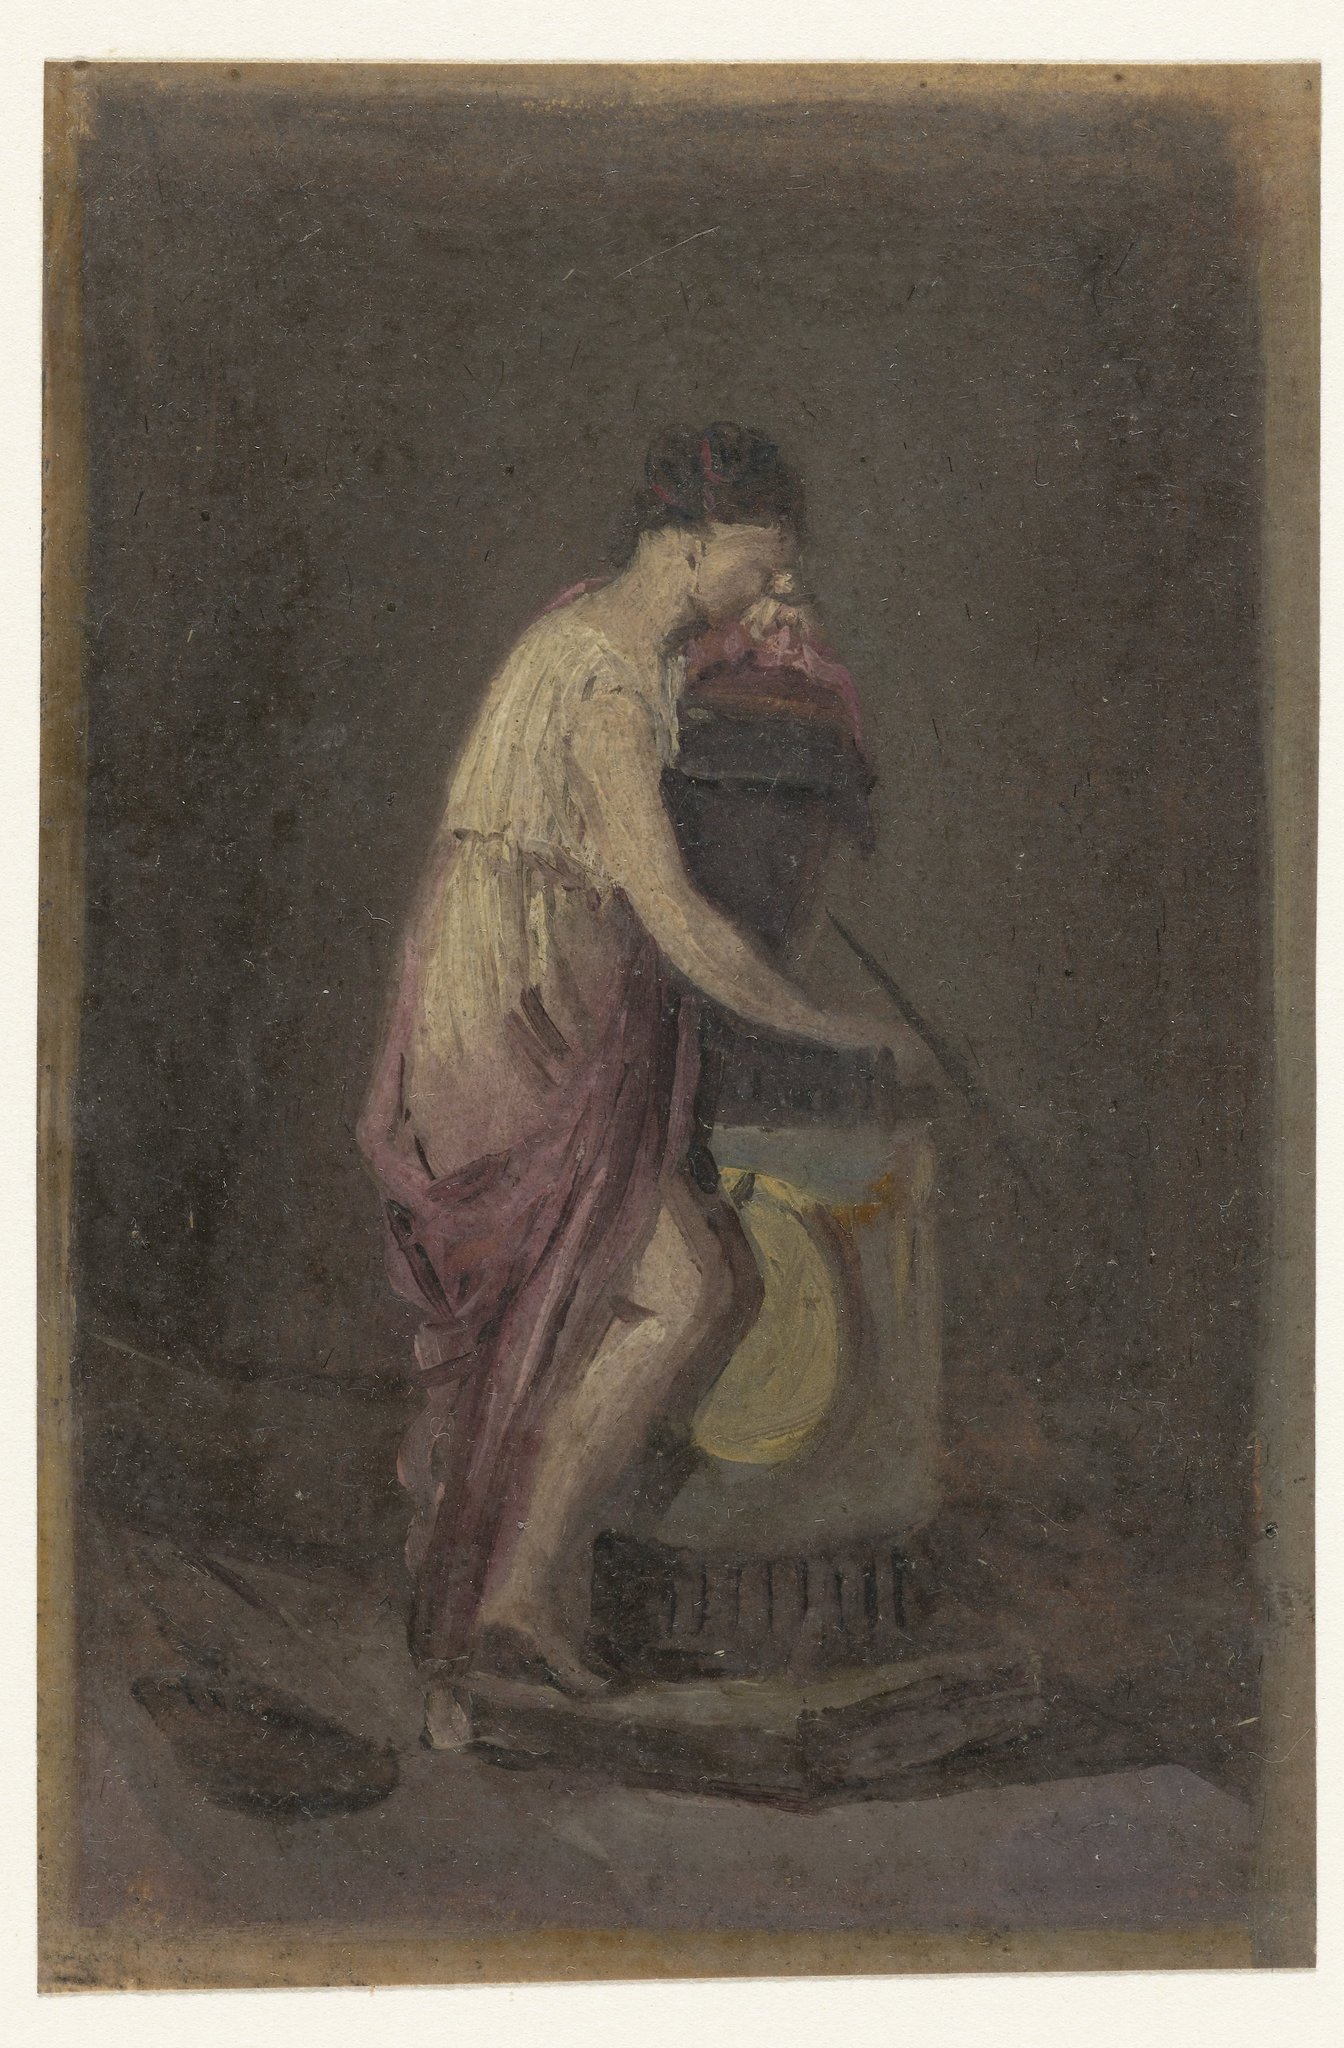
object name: drawing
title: Staande treurende vrouw bij een grafmonument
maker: Anonymous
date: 1700-1800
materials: oil, paper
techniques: brush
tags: urn, mourning the dead